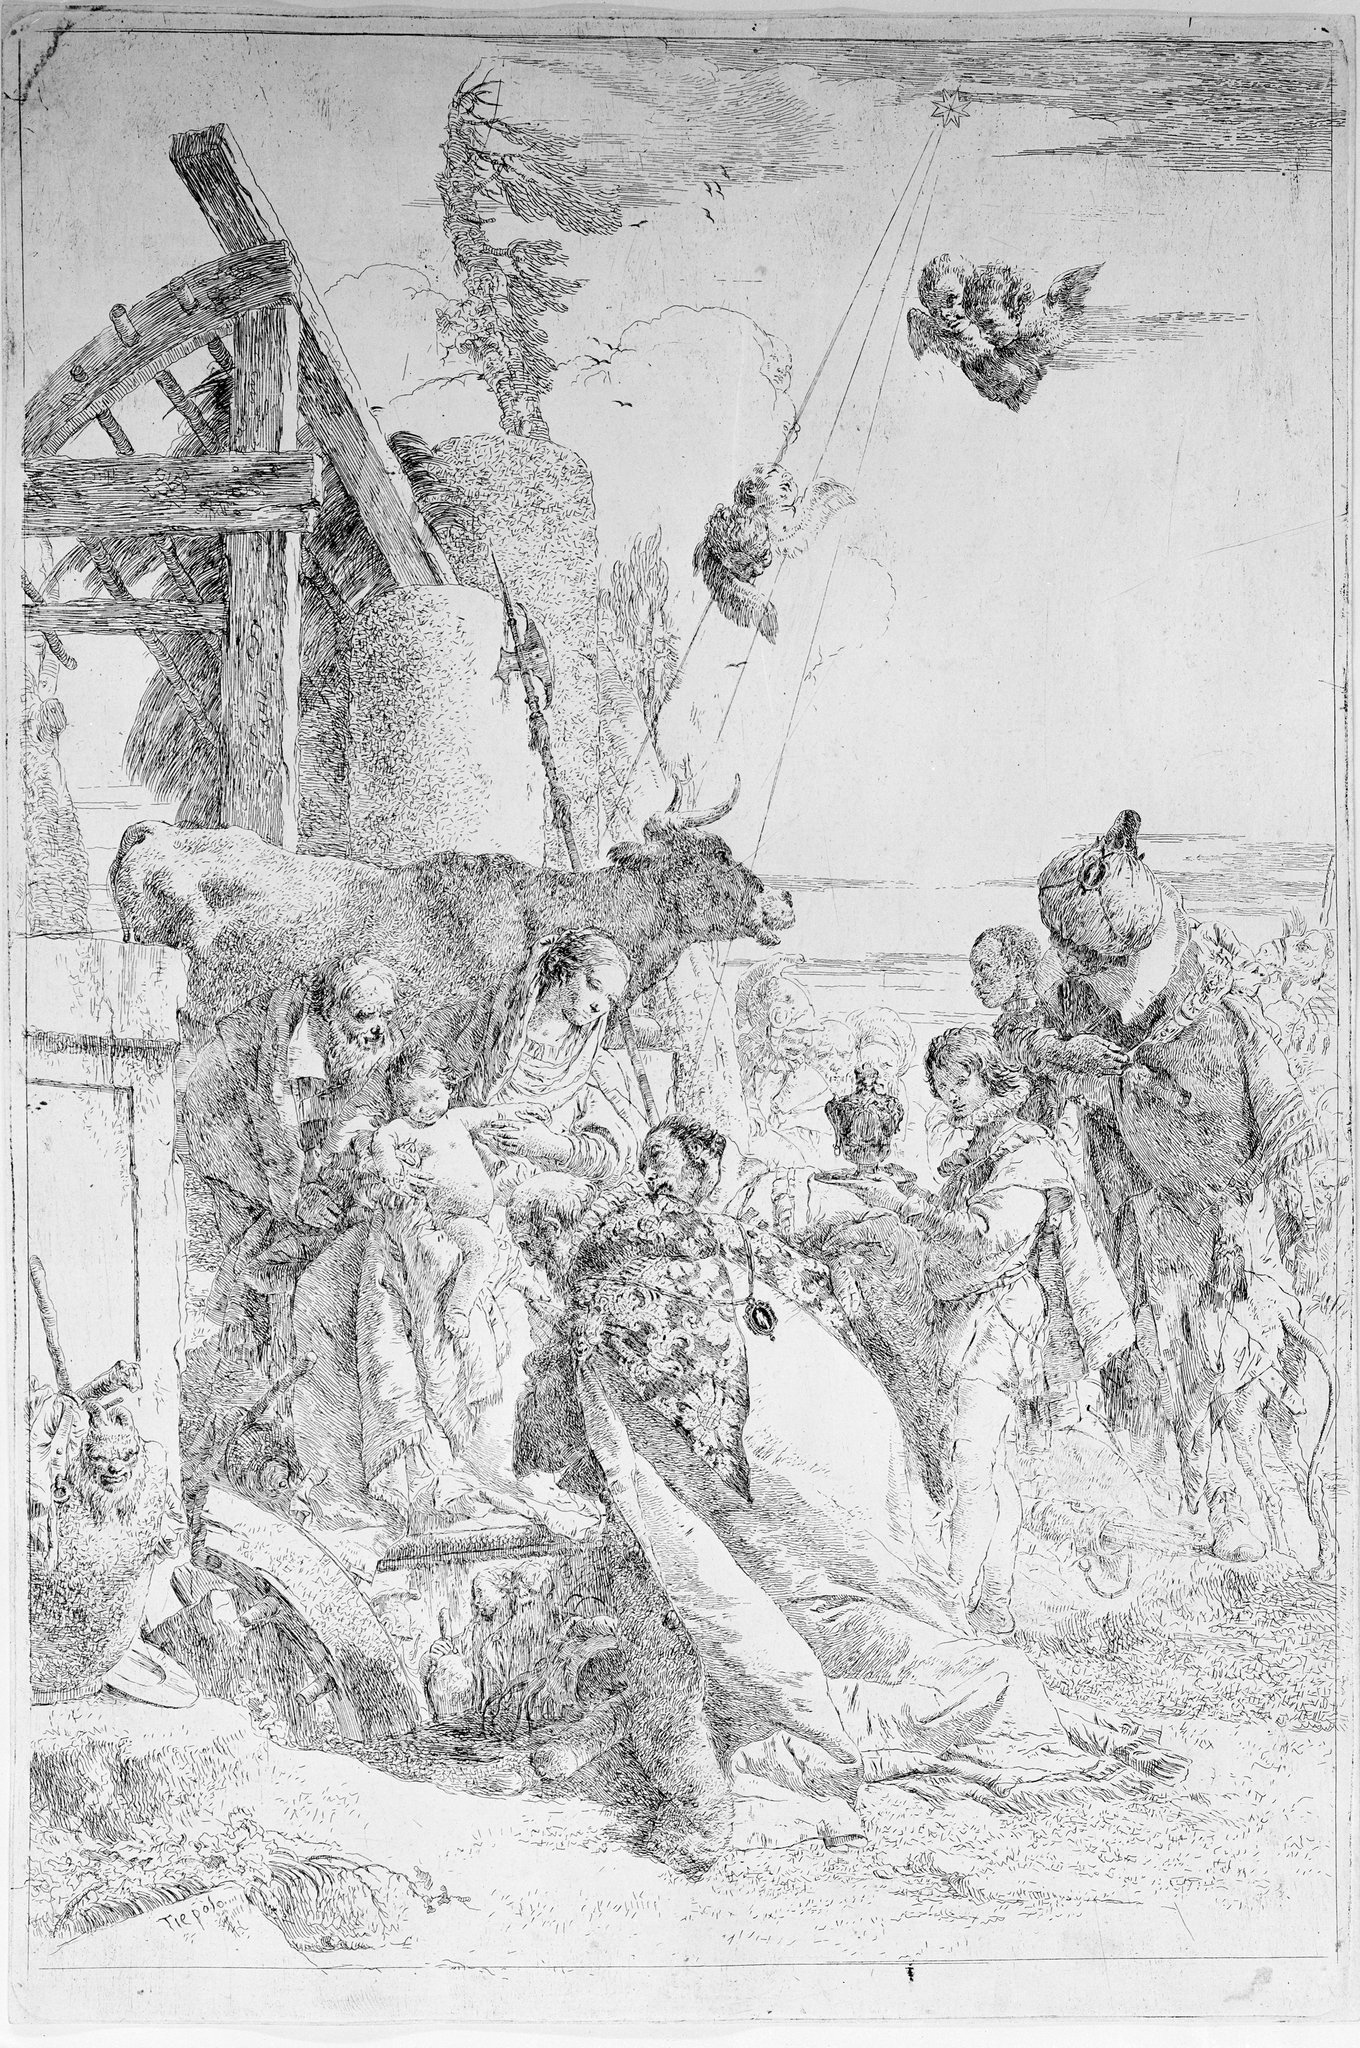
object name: print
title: Adoration of the Magi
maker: giovanni battista tiepolo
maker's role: artist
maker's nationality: italian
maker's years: 1696-1770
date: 1753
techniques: etching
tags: adoration of the magi